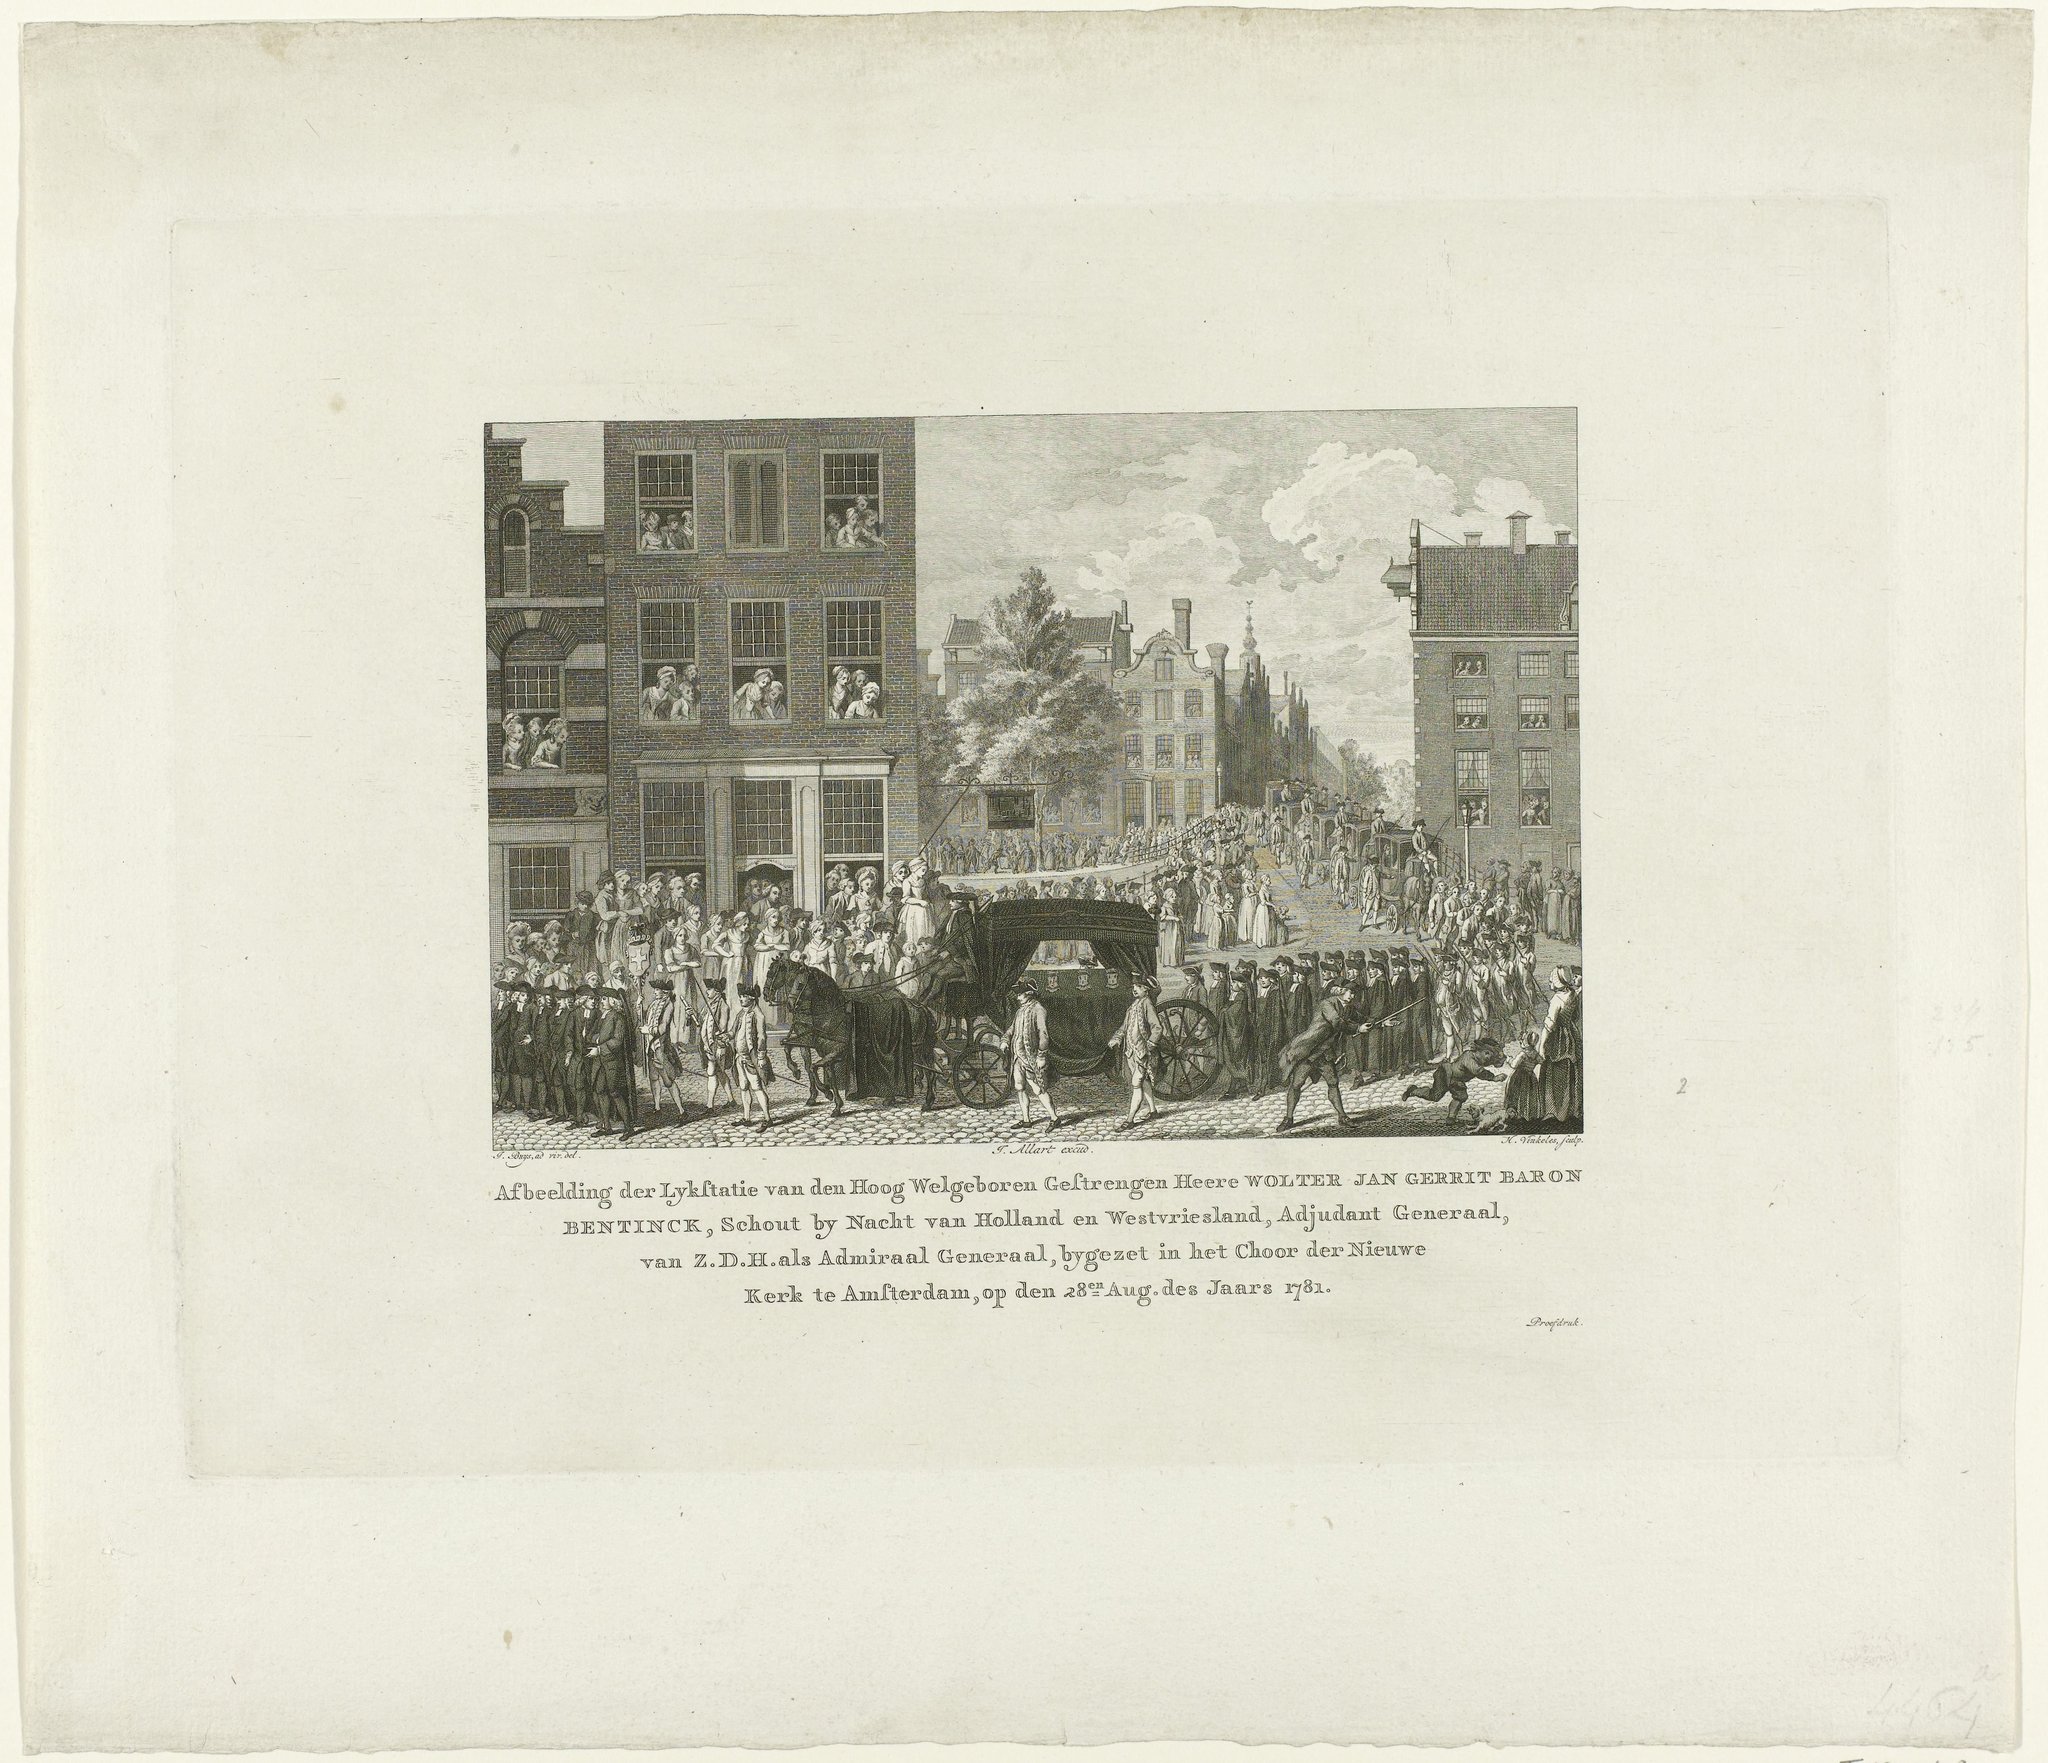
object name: print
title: Afbeelding der lykstatie van den Hoog Welgeboren Gestrengen Heere Wolter Jan Gerrit baron Bentinck (...) bygezet in het choor der Nieuwe Kerk te Amsterdam, op den 28en. aug. des jaars 1781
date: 1782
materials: paper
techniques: engraving, etching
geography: amsterdam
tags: amsterdam, funeral carriages, cortege, funeral procession, public funeral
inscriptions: collector's mark: Lugt 2228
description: Latere (derde) staat van deze prent was bestemd voor gebruik als illustratie in: Francq van Berkhey, Johannes le. De zeetriumph der Bataafsche vryheid, op Doggersbank. Bevochten den 5den van Oogstmaand 1781. 2 delen. Amsterdam: Johannes Allart, 1782. De prent was echter niet op tijd klaar om in het boek opgenomen te worden, maar werd alsnog later door de uitgever aan de intekenaren geleverd. Voor eerste bekende staat zie RP-P-OB-85.212. Voor derde bekende staat zie RP-P-AO-28-110. Voor vierde bekende staat zie RP-P-1944-1923.